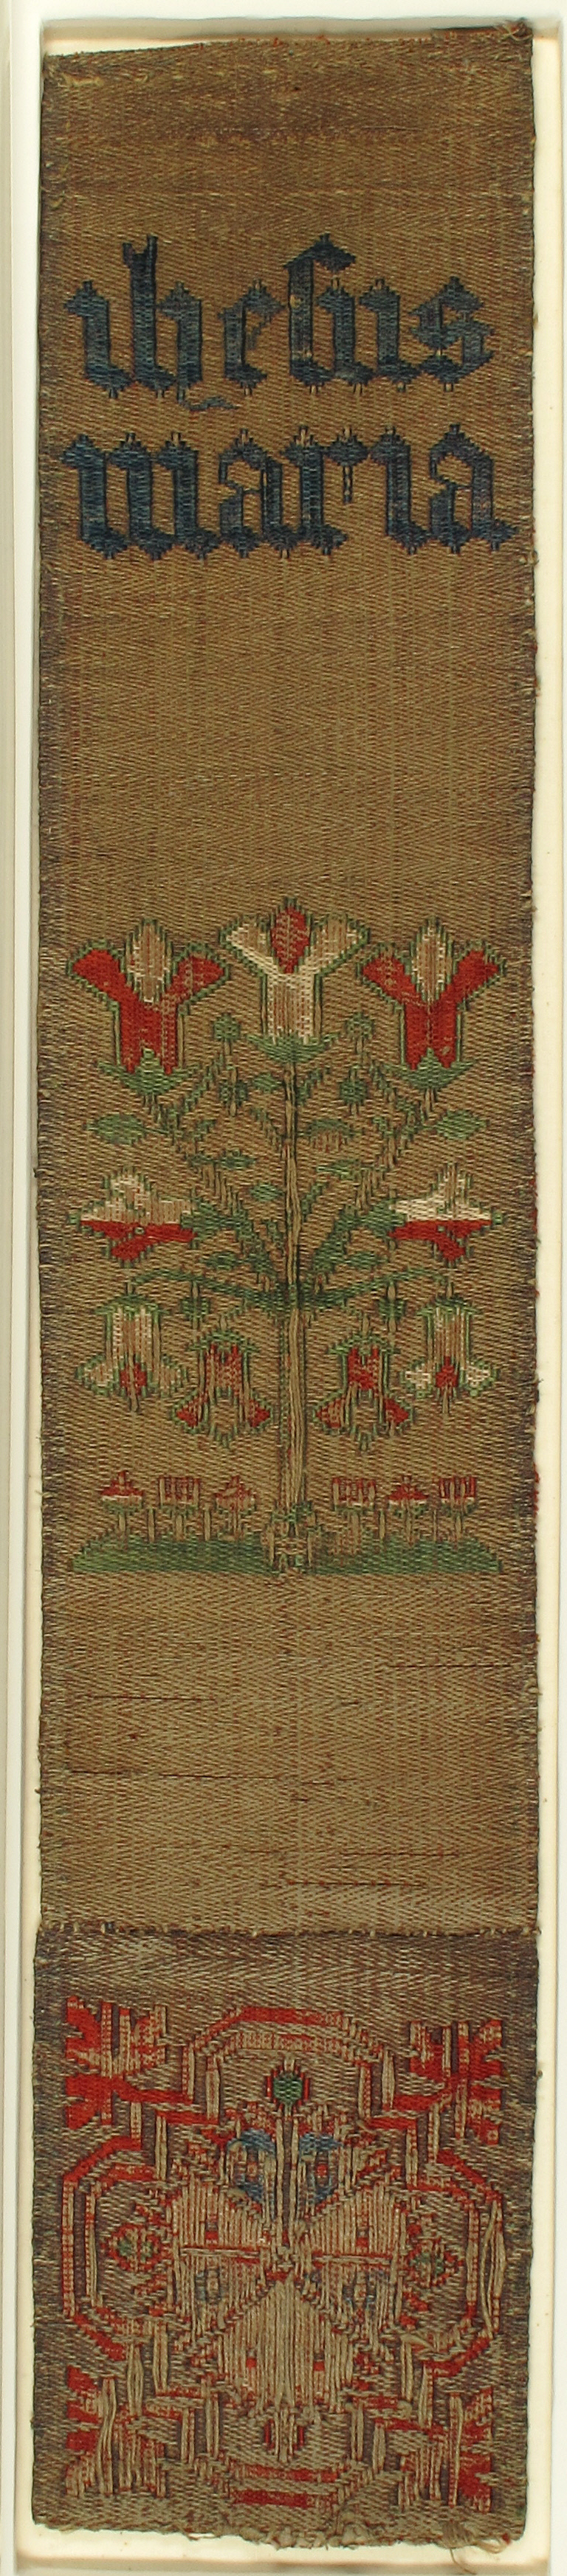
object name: textile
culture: german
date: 1401-1500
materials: linen, metal thread, silk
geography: germany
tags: plants